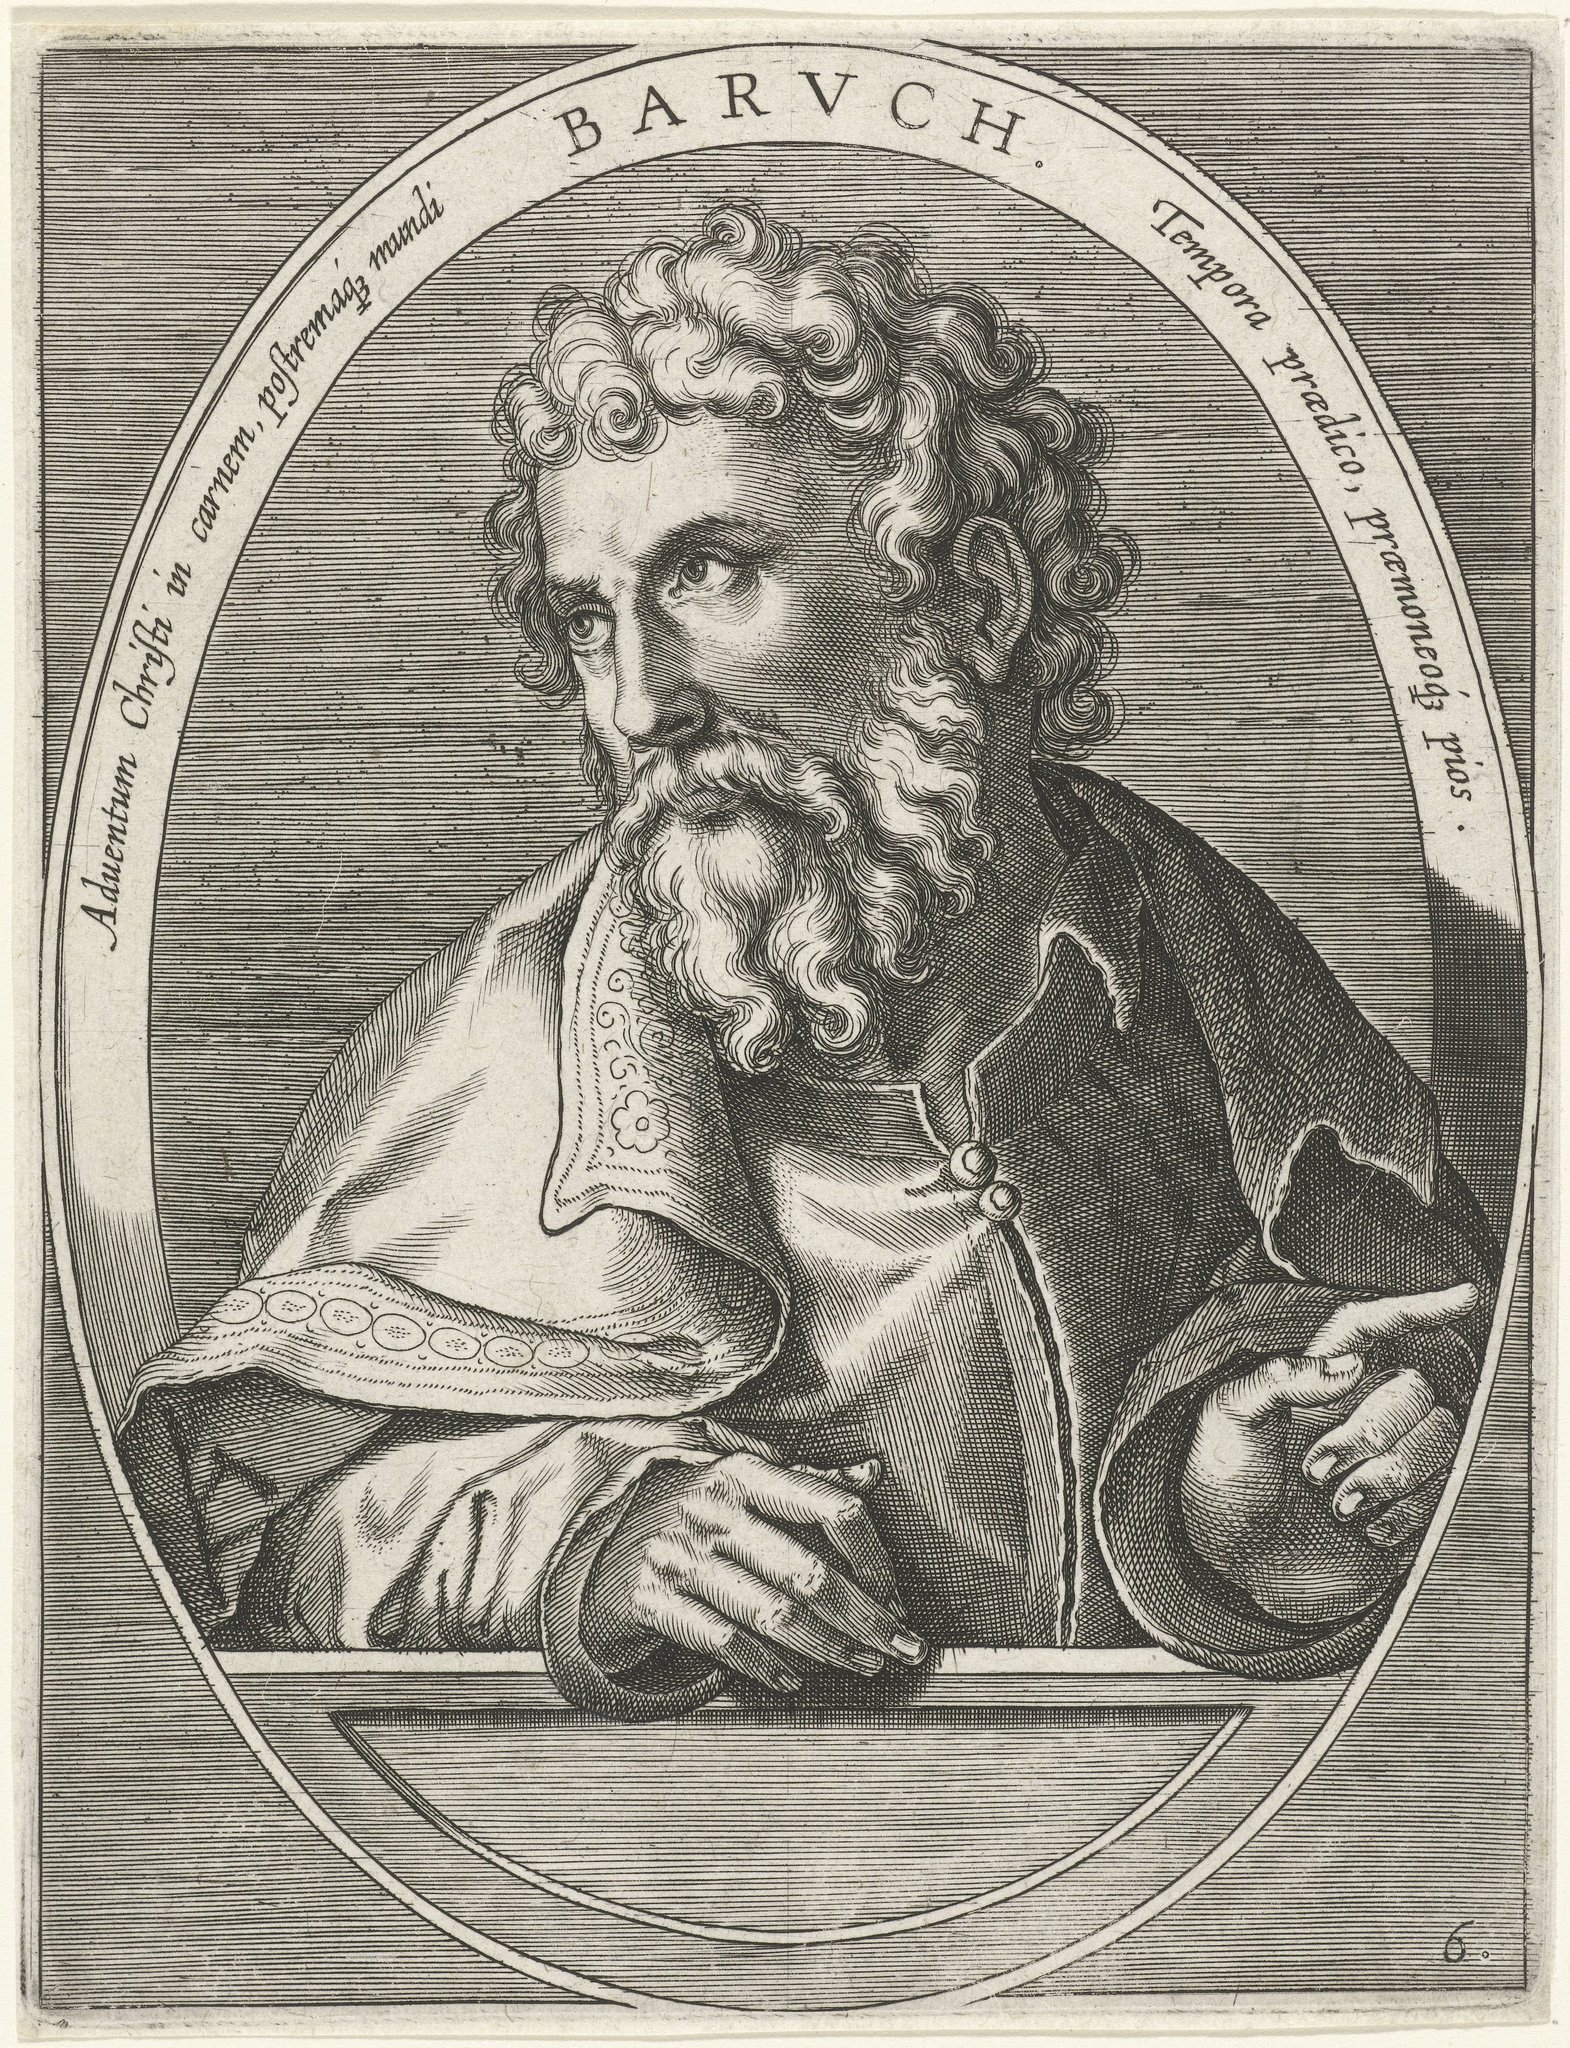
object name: print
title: Icones Prophetarum Veteris Testamenti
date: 1613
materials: paper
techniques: engraving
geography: antwerp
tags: the book of baruch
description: De schrijver van de profeet Jeremia, Baruch, in ovaal met Latijns randschrift.